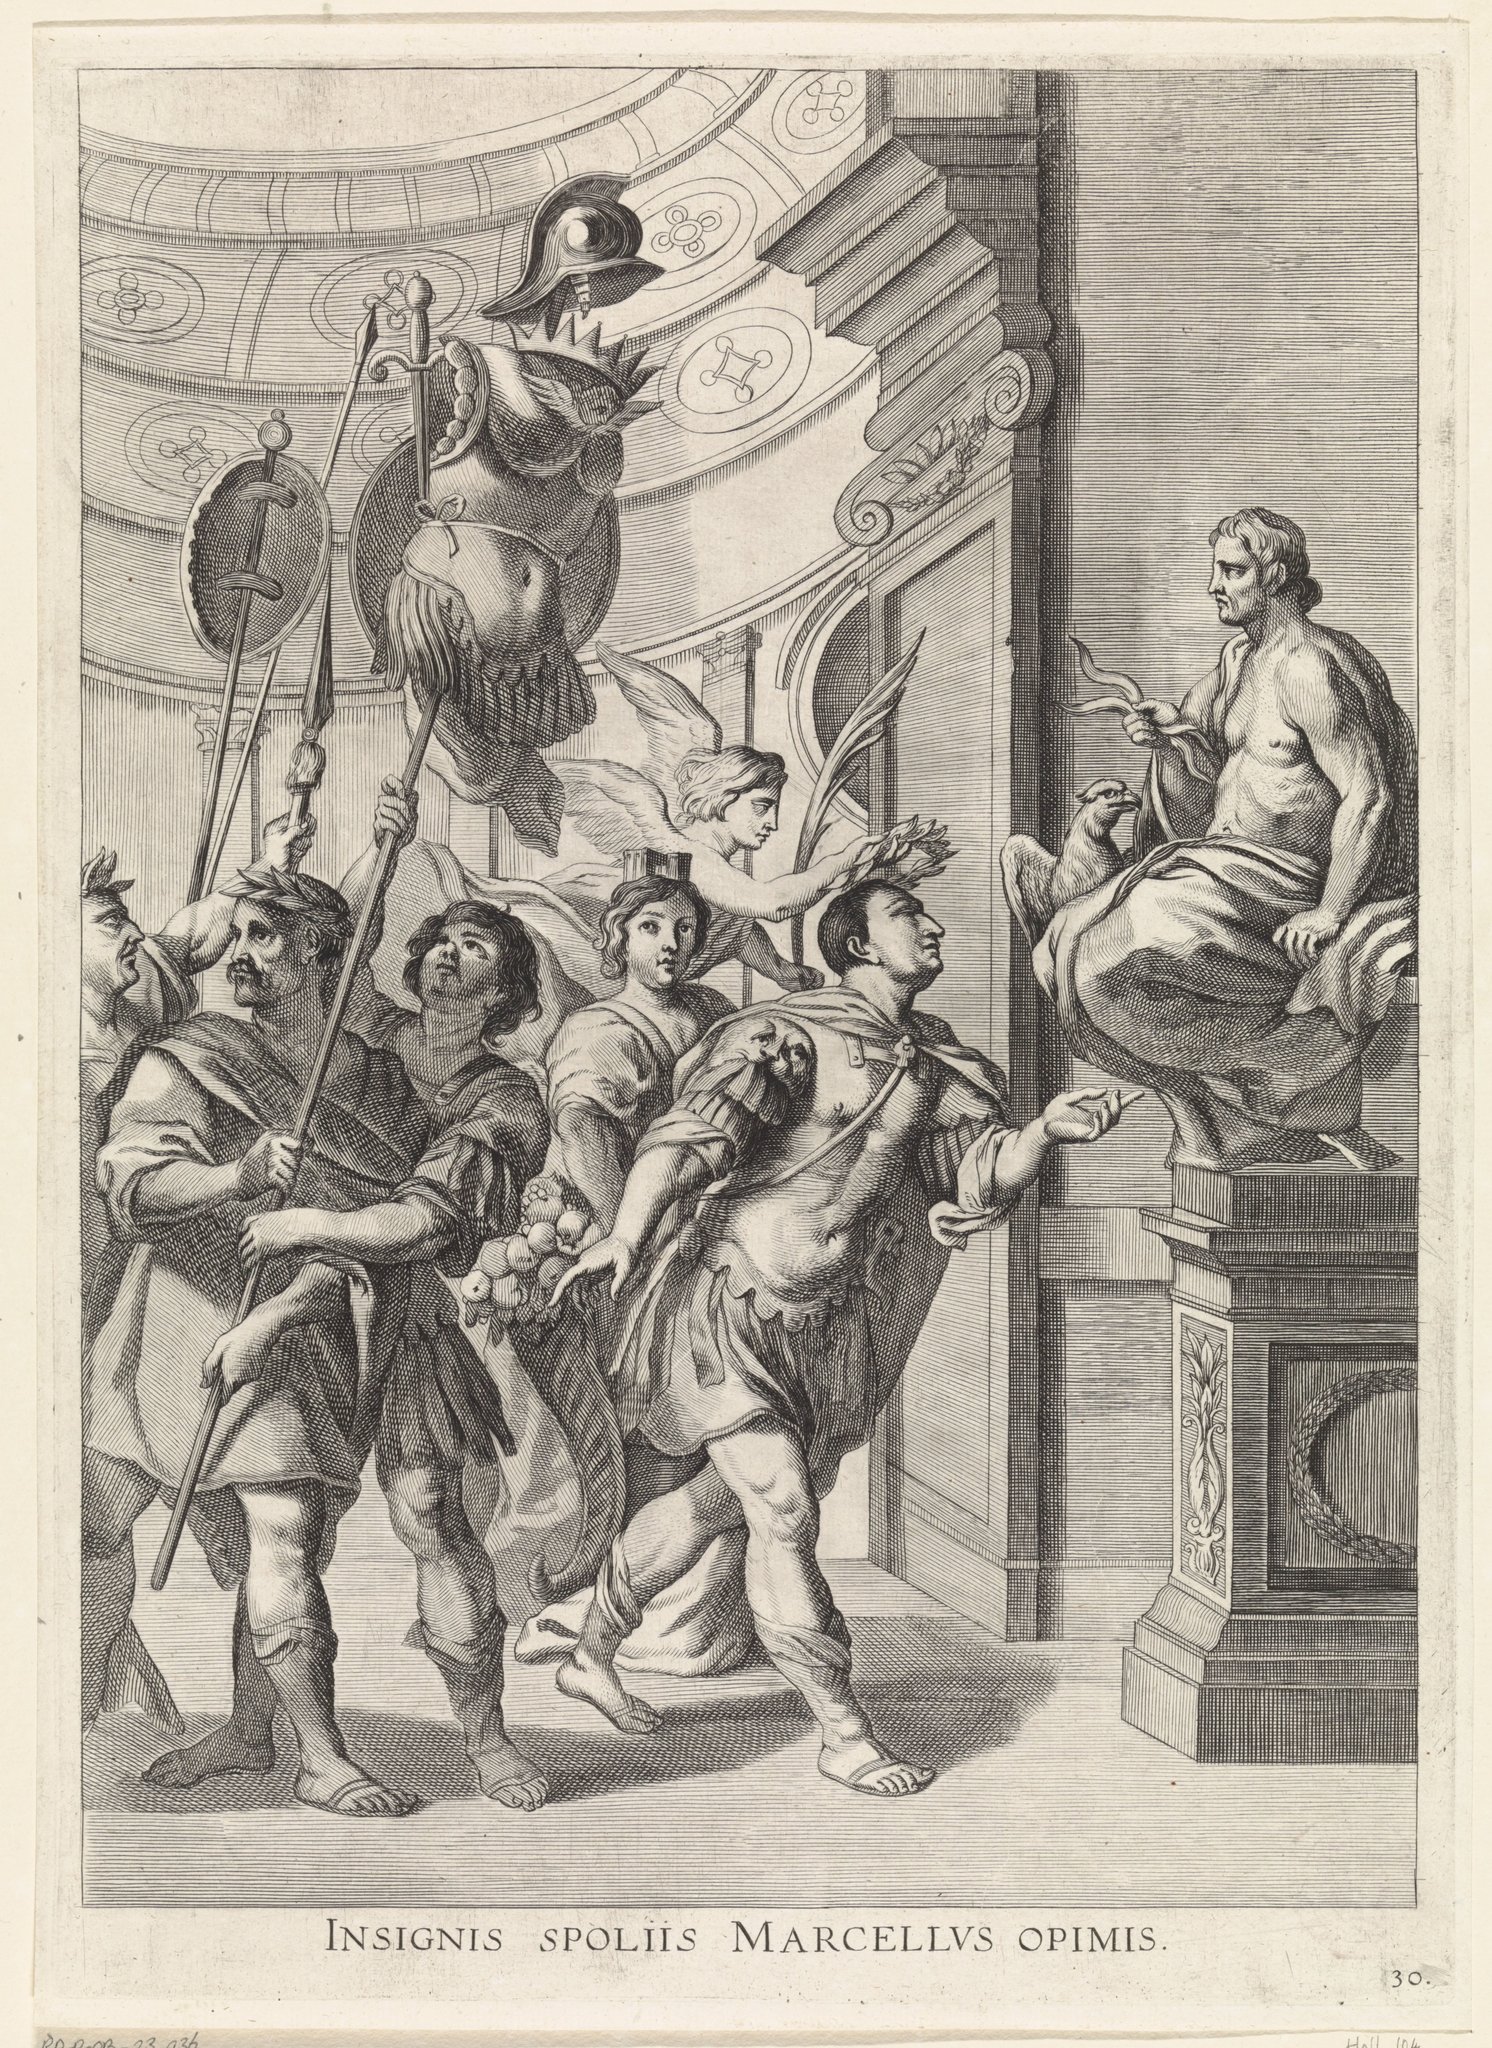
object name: print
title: Insignis spoliis Marcellus opimis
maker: jacob neefs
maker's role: print maker, publisher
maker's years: 1610-1660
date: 1636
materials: paper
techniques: engraving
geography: antwerp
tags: victor (after the battle), triumphal entry and public reception, pageant, 'entrée solennelle', 'joyeuse entrée', (story of) jupiter (zeus), armour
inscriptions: collector's mark: Lugt 240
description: In een tempel offert Marcus Claudius Marcellus de in het jaar 222 v.Chr. op Viridomarus, de aanvoerder van de Galliërs, buitgemaakte wapenrusting aan Jupiter. Voorstelling linksonder op de achterzijde van de triomfpoorten Arcus Caroli op de Vrijdagmarkt. Prent maakt deel uit van een serie, die de uitgave van de beschrijving van de intocht van de Kardinaal Infant Ferdinand van Oostenrijk te Gent op 28 januari 1635 als de nieuwe landvoogd voor de Spaanse Nederlanden illustreert.